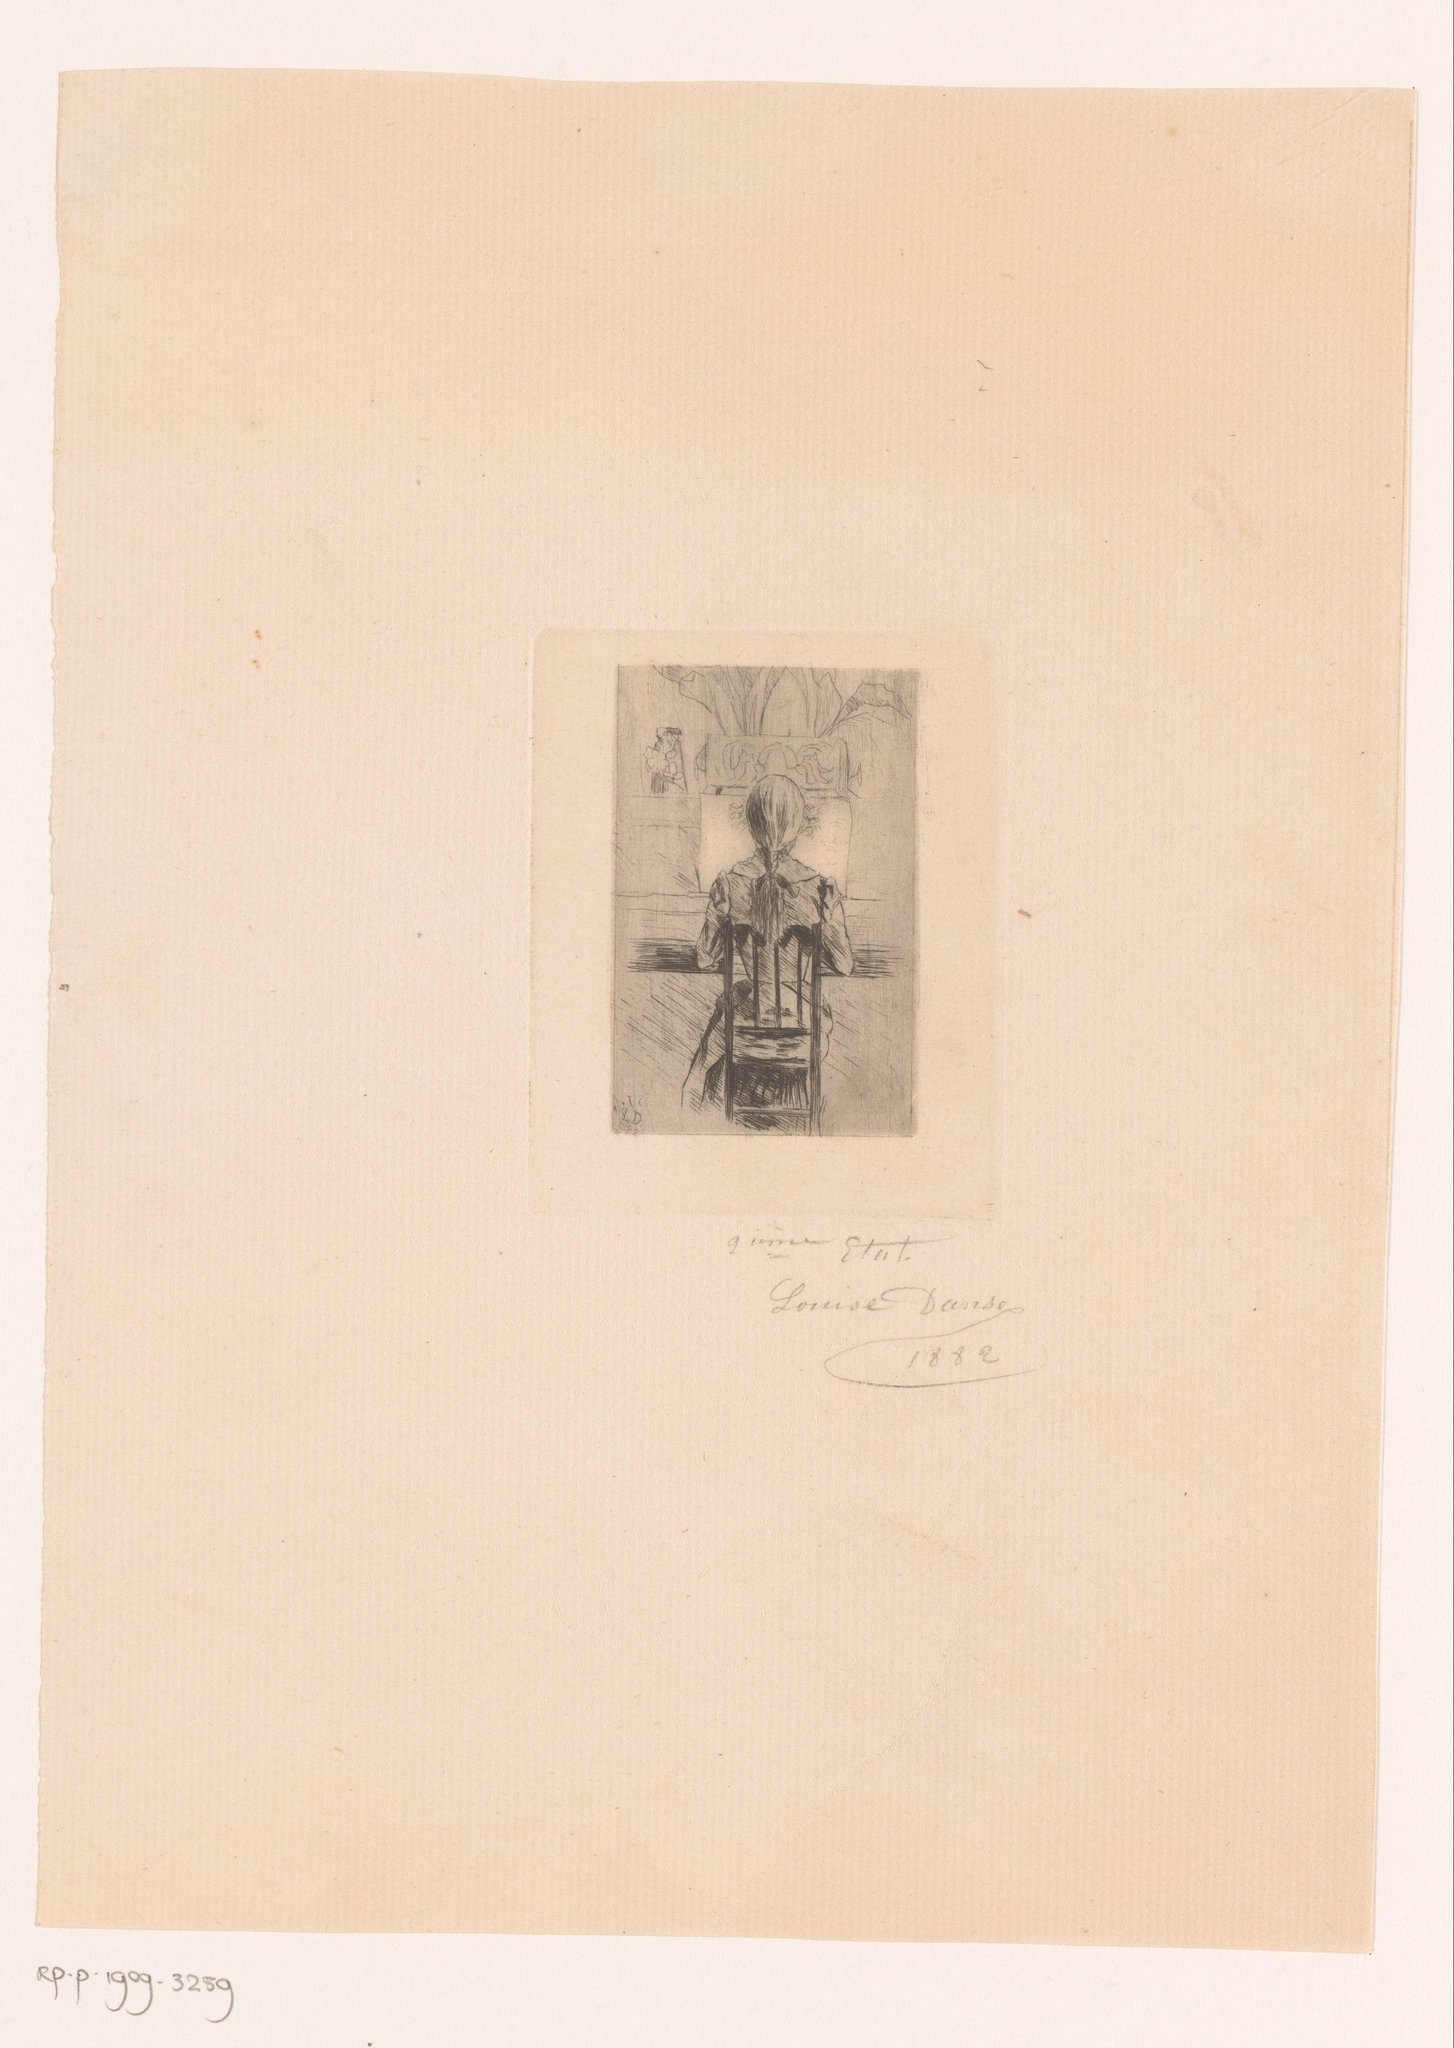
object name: print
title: Pianospelend meisje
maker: louise danse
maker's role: painter, print maker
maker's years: 1867-1948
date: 1882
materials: paper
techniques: etching, intaglio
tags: one person playing keyboard instrument, girl (child between toddler and youth), pianoforte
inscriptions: collector's mark: Lugt 2228, annotation: ‘2ième état’